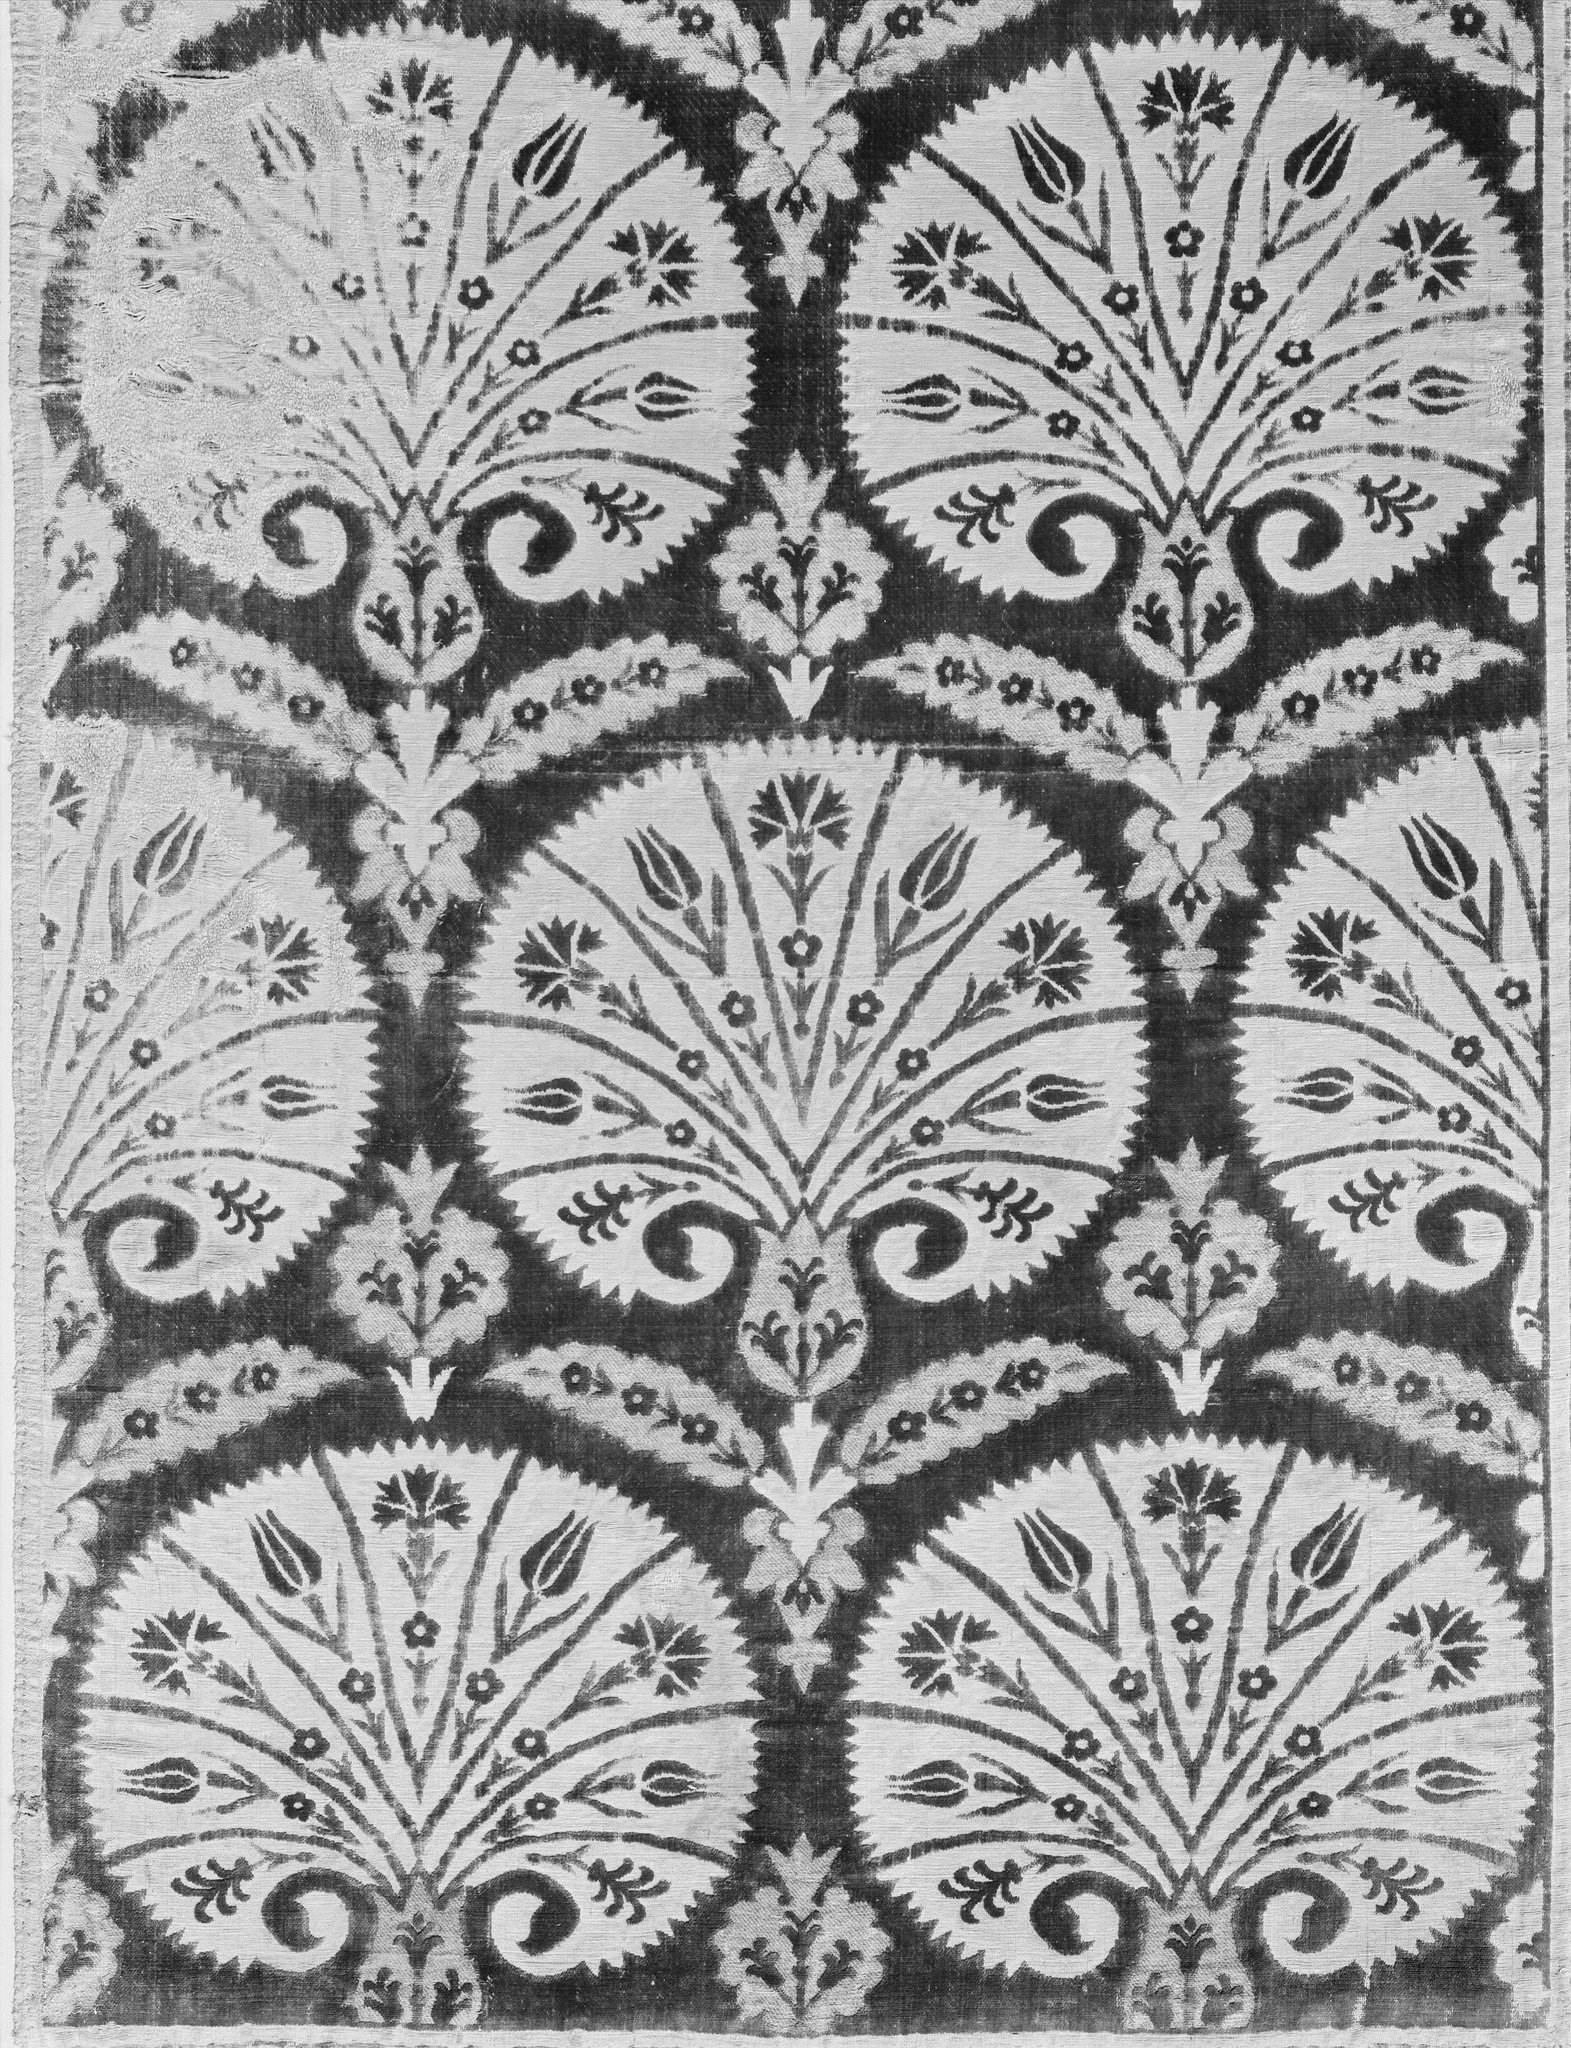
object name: panel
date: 1601-1700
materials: metal thread, silk, velvet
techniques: cutting, voiding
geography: turkey